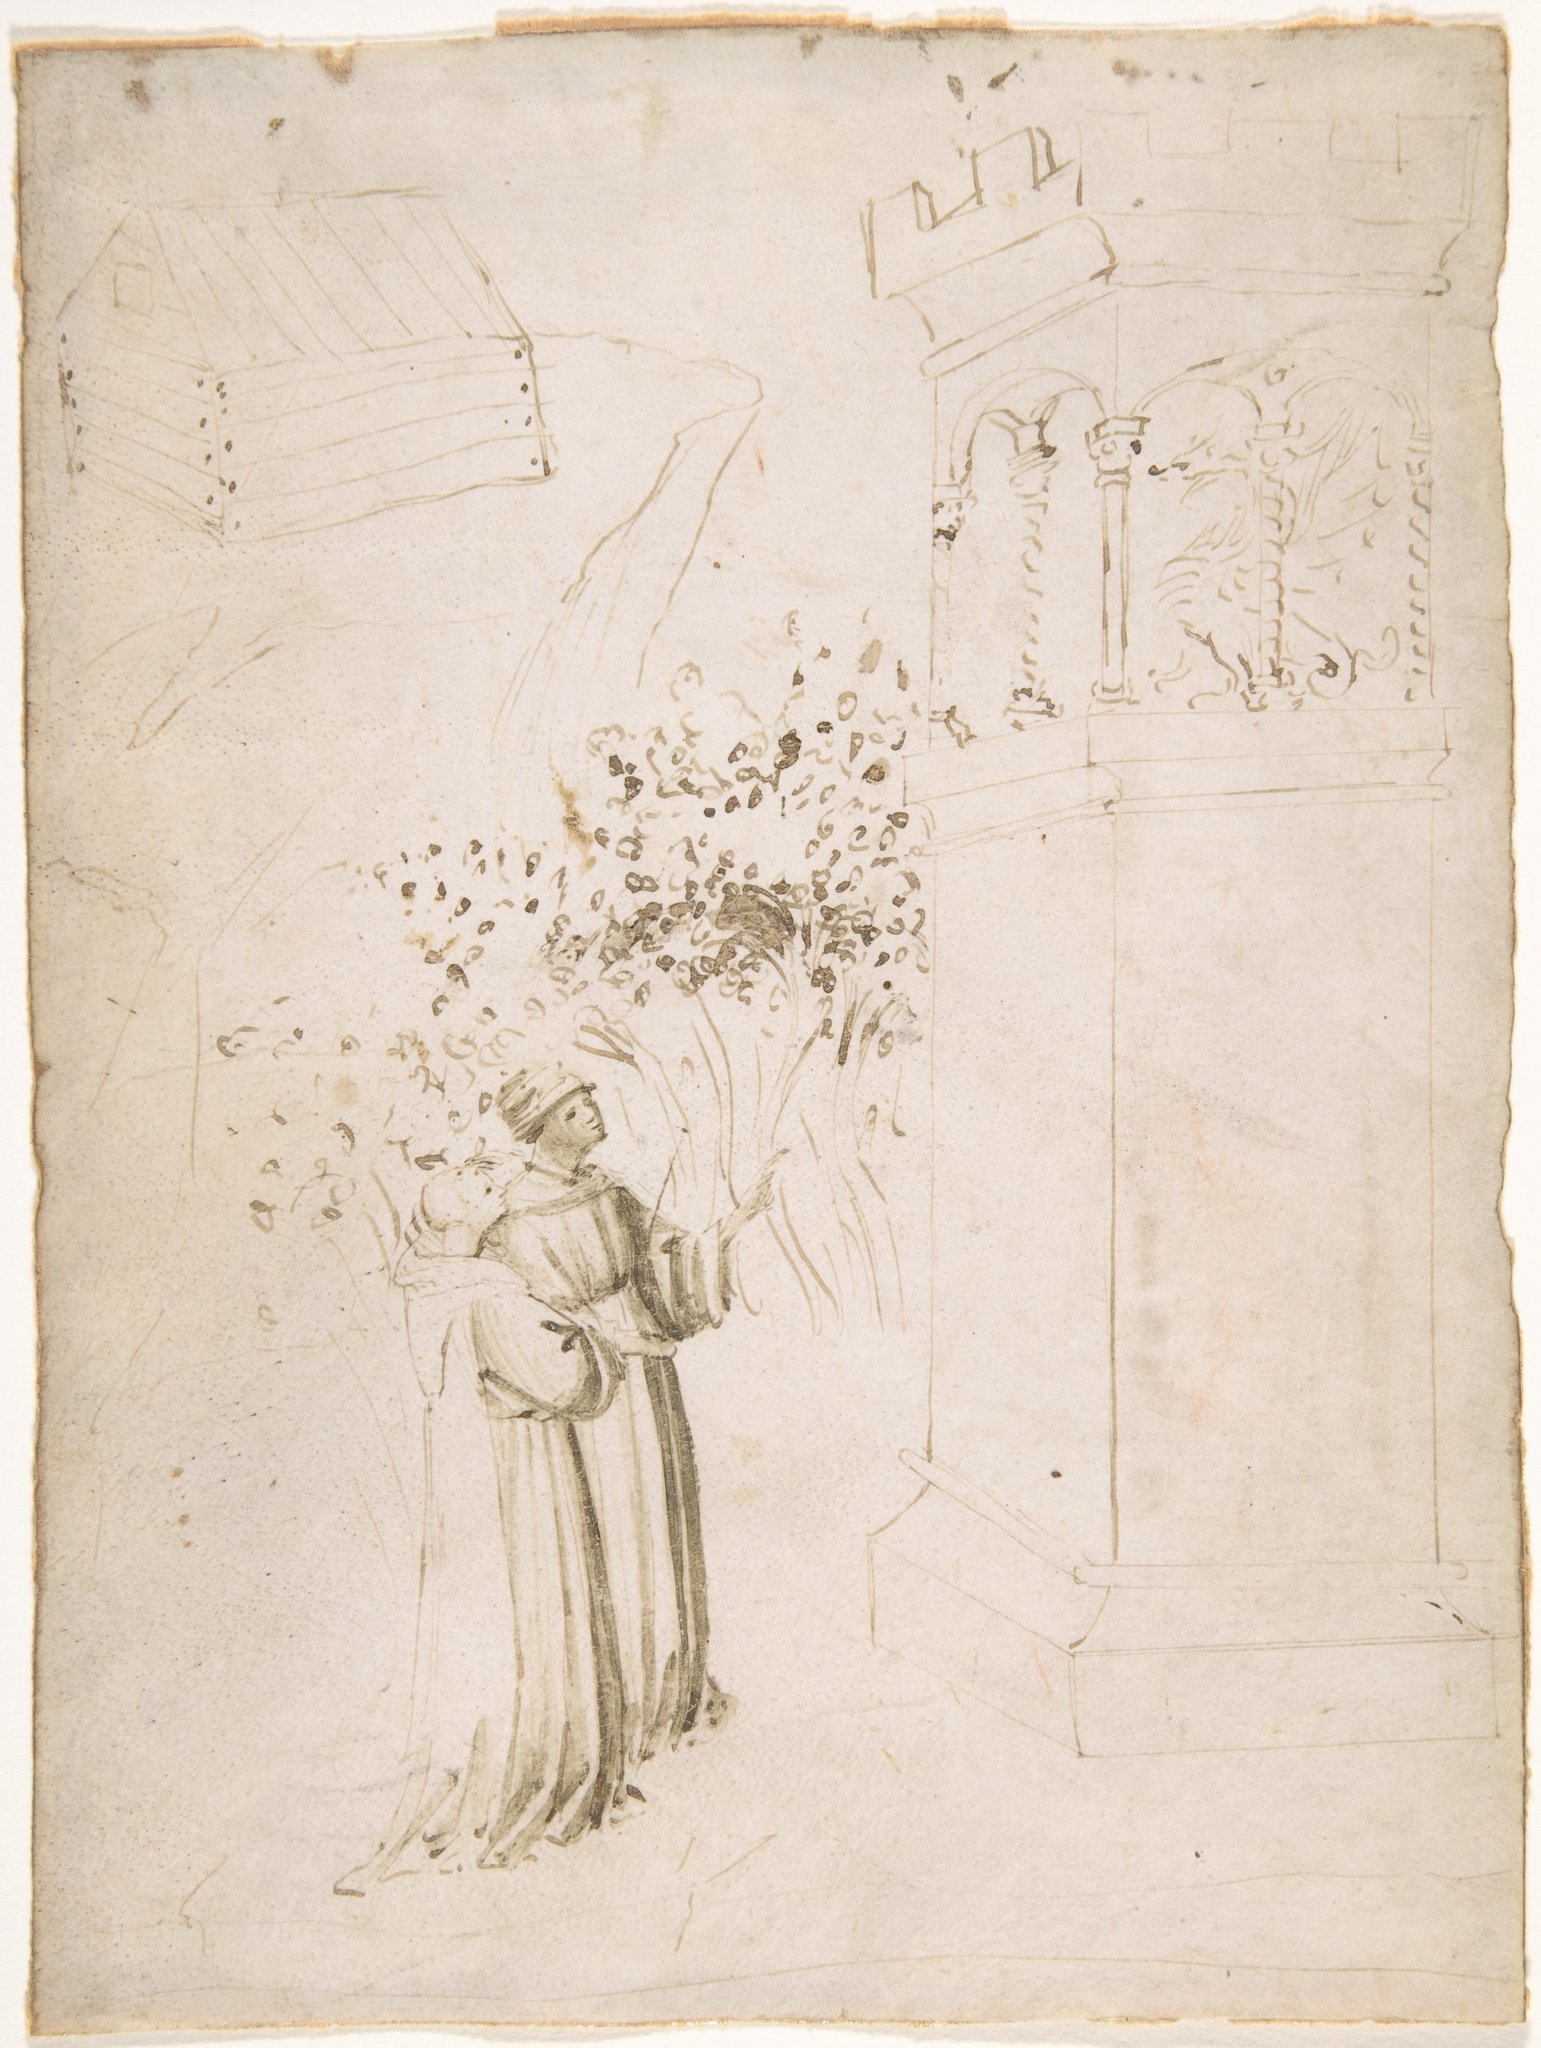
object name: drawing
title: Two Monks Looking up at a Dragon in a Tower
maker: anonymous, italian, tuscan, early 15th century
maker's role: artist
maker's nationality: italian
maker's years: 1400-1425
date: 1500-1550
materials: ink, parchment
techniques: brush, pen, wash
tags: towers,dragons,monks